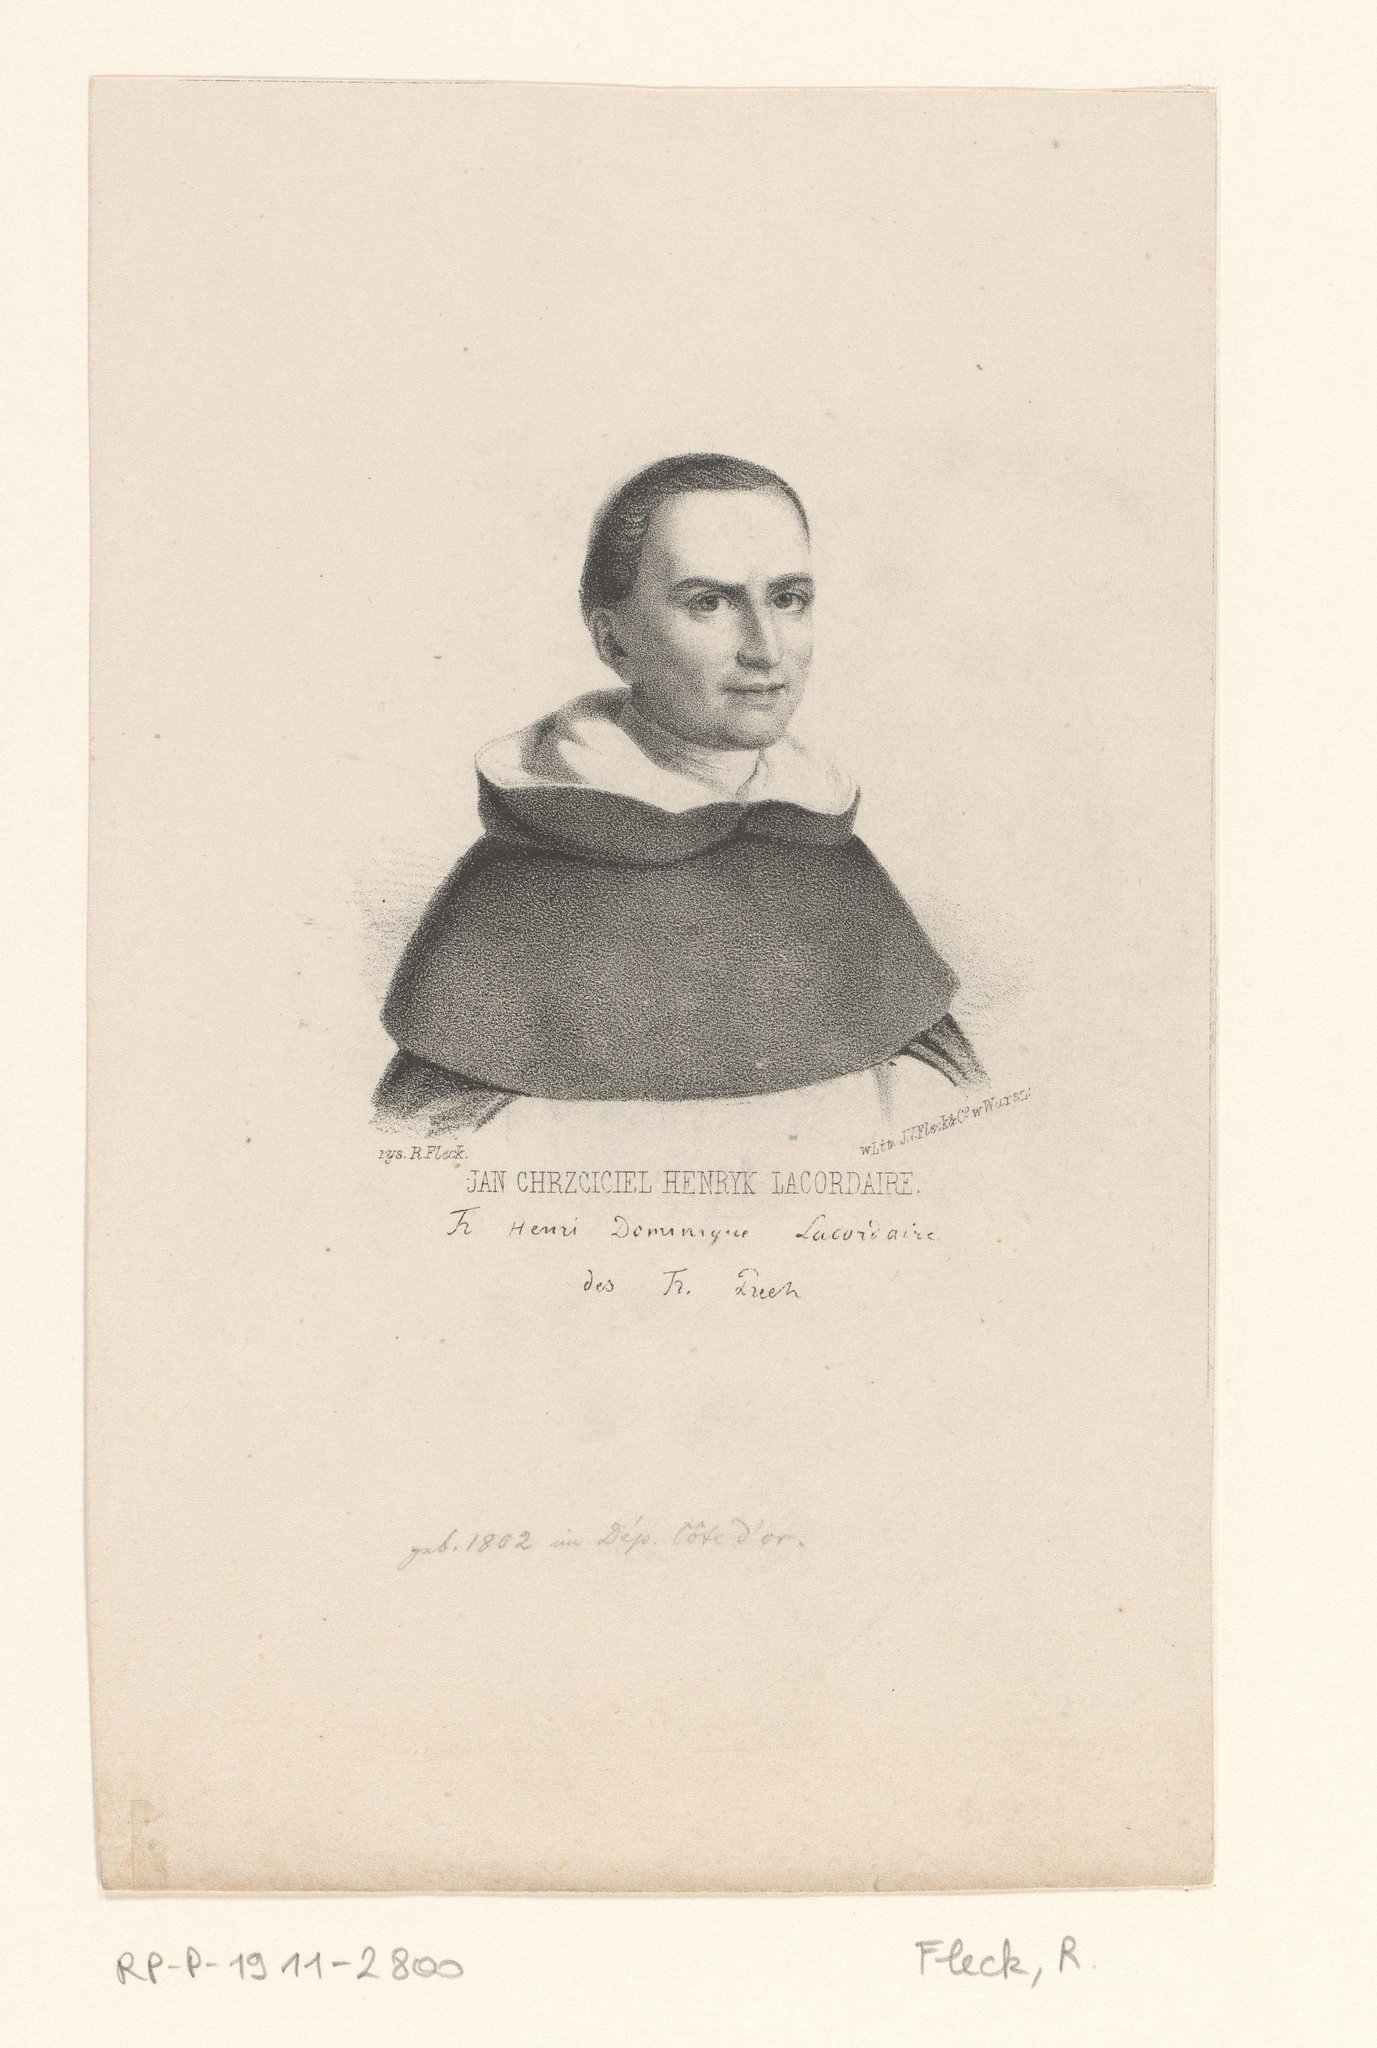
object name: print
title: Jan Chrzciciel Henryk Lacordaire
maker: rudolf fleck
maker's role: print maker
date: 1820-1860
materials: paper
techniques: lithograph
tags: jean-baptiste henri lacordaire, adult man, historical persons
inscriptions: collector's mark: Lugt 2228